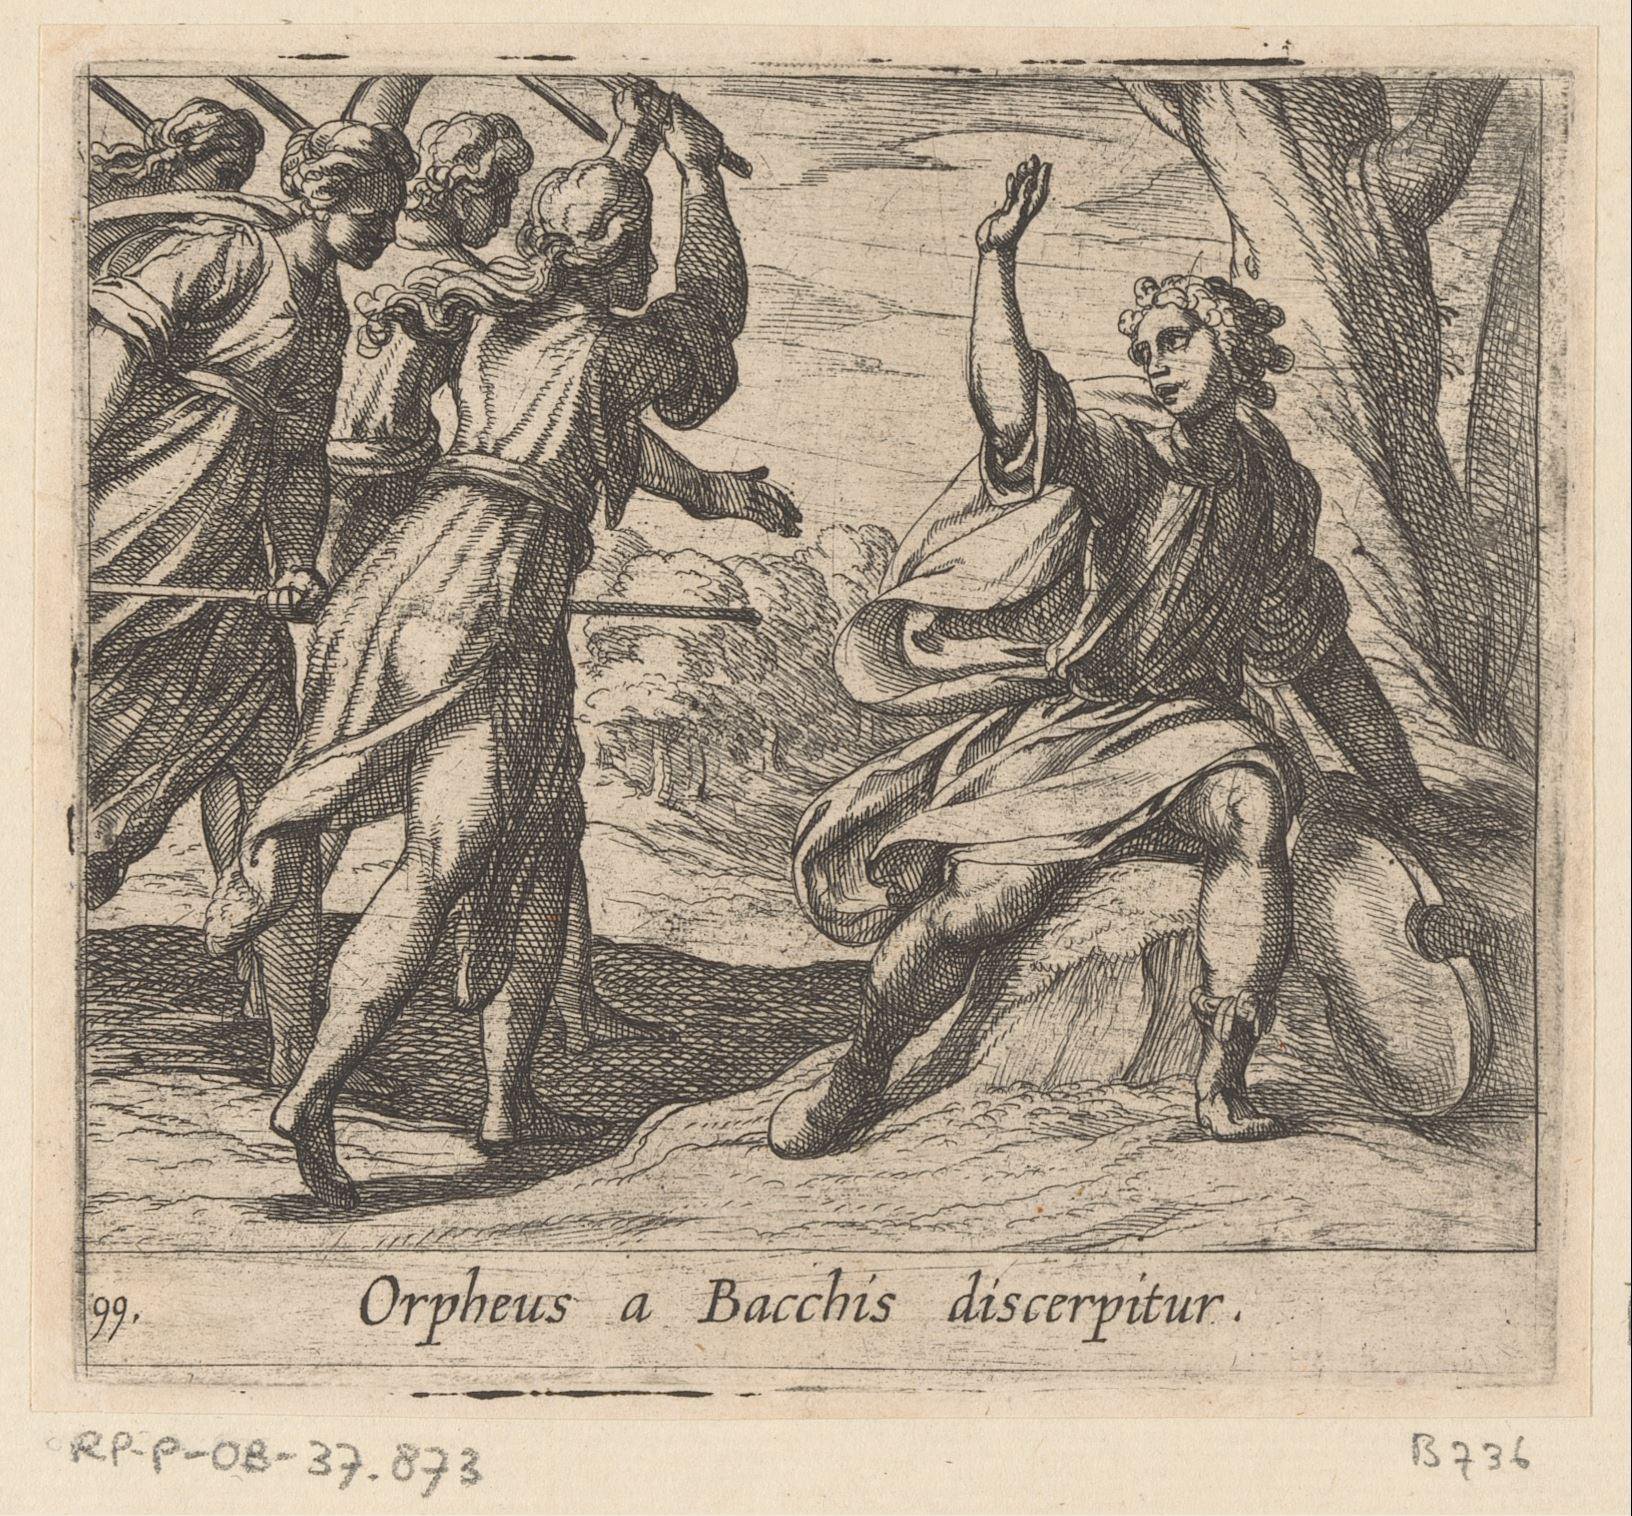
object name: print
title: Dood van Orpheus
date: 1606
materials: paper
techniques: etching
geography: italy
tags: death of orpheus: he is torn to pieces by the thracian women during a bacchic orgy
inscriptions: collector's mark: Lugt 240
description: Deze prent maakt deel uit van een reeks van 150 prenten (+ titelprent) met voorstellingen van de Metamorfosen van Ovidius.